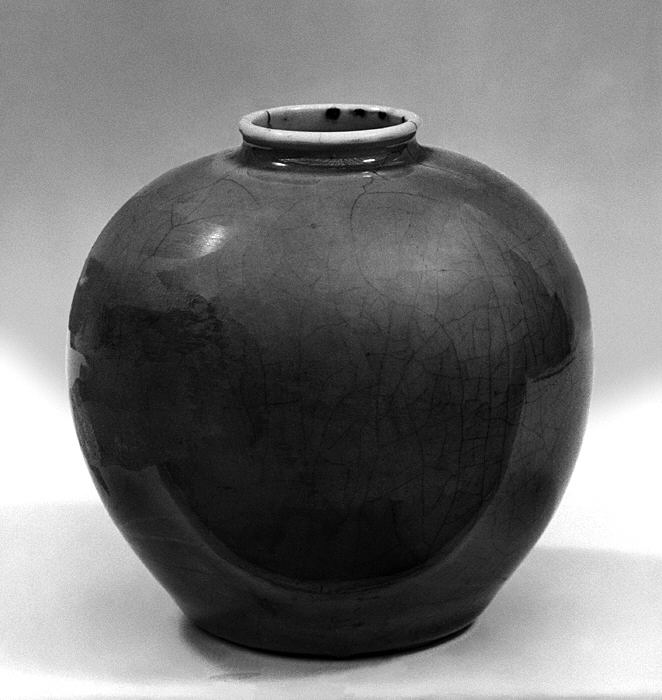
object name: jar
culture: chinese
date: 1801-1900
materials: glaze, porcelain